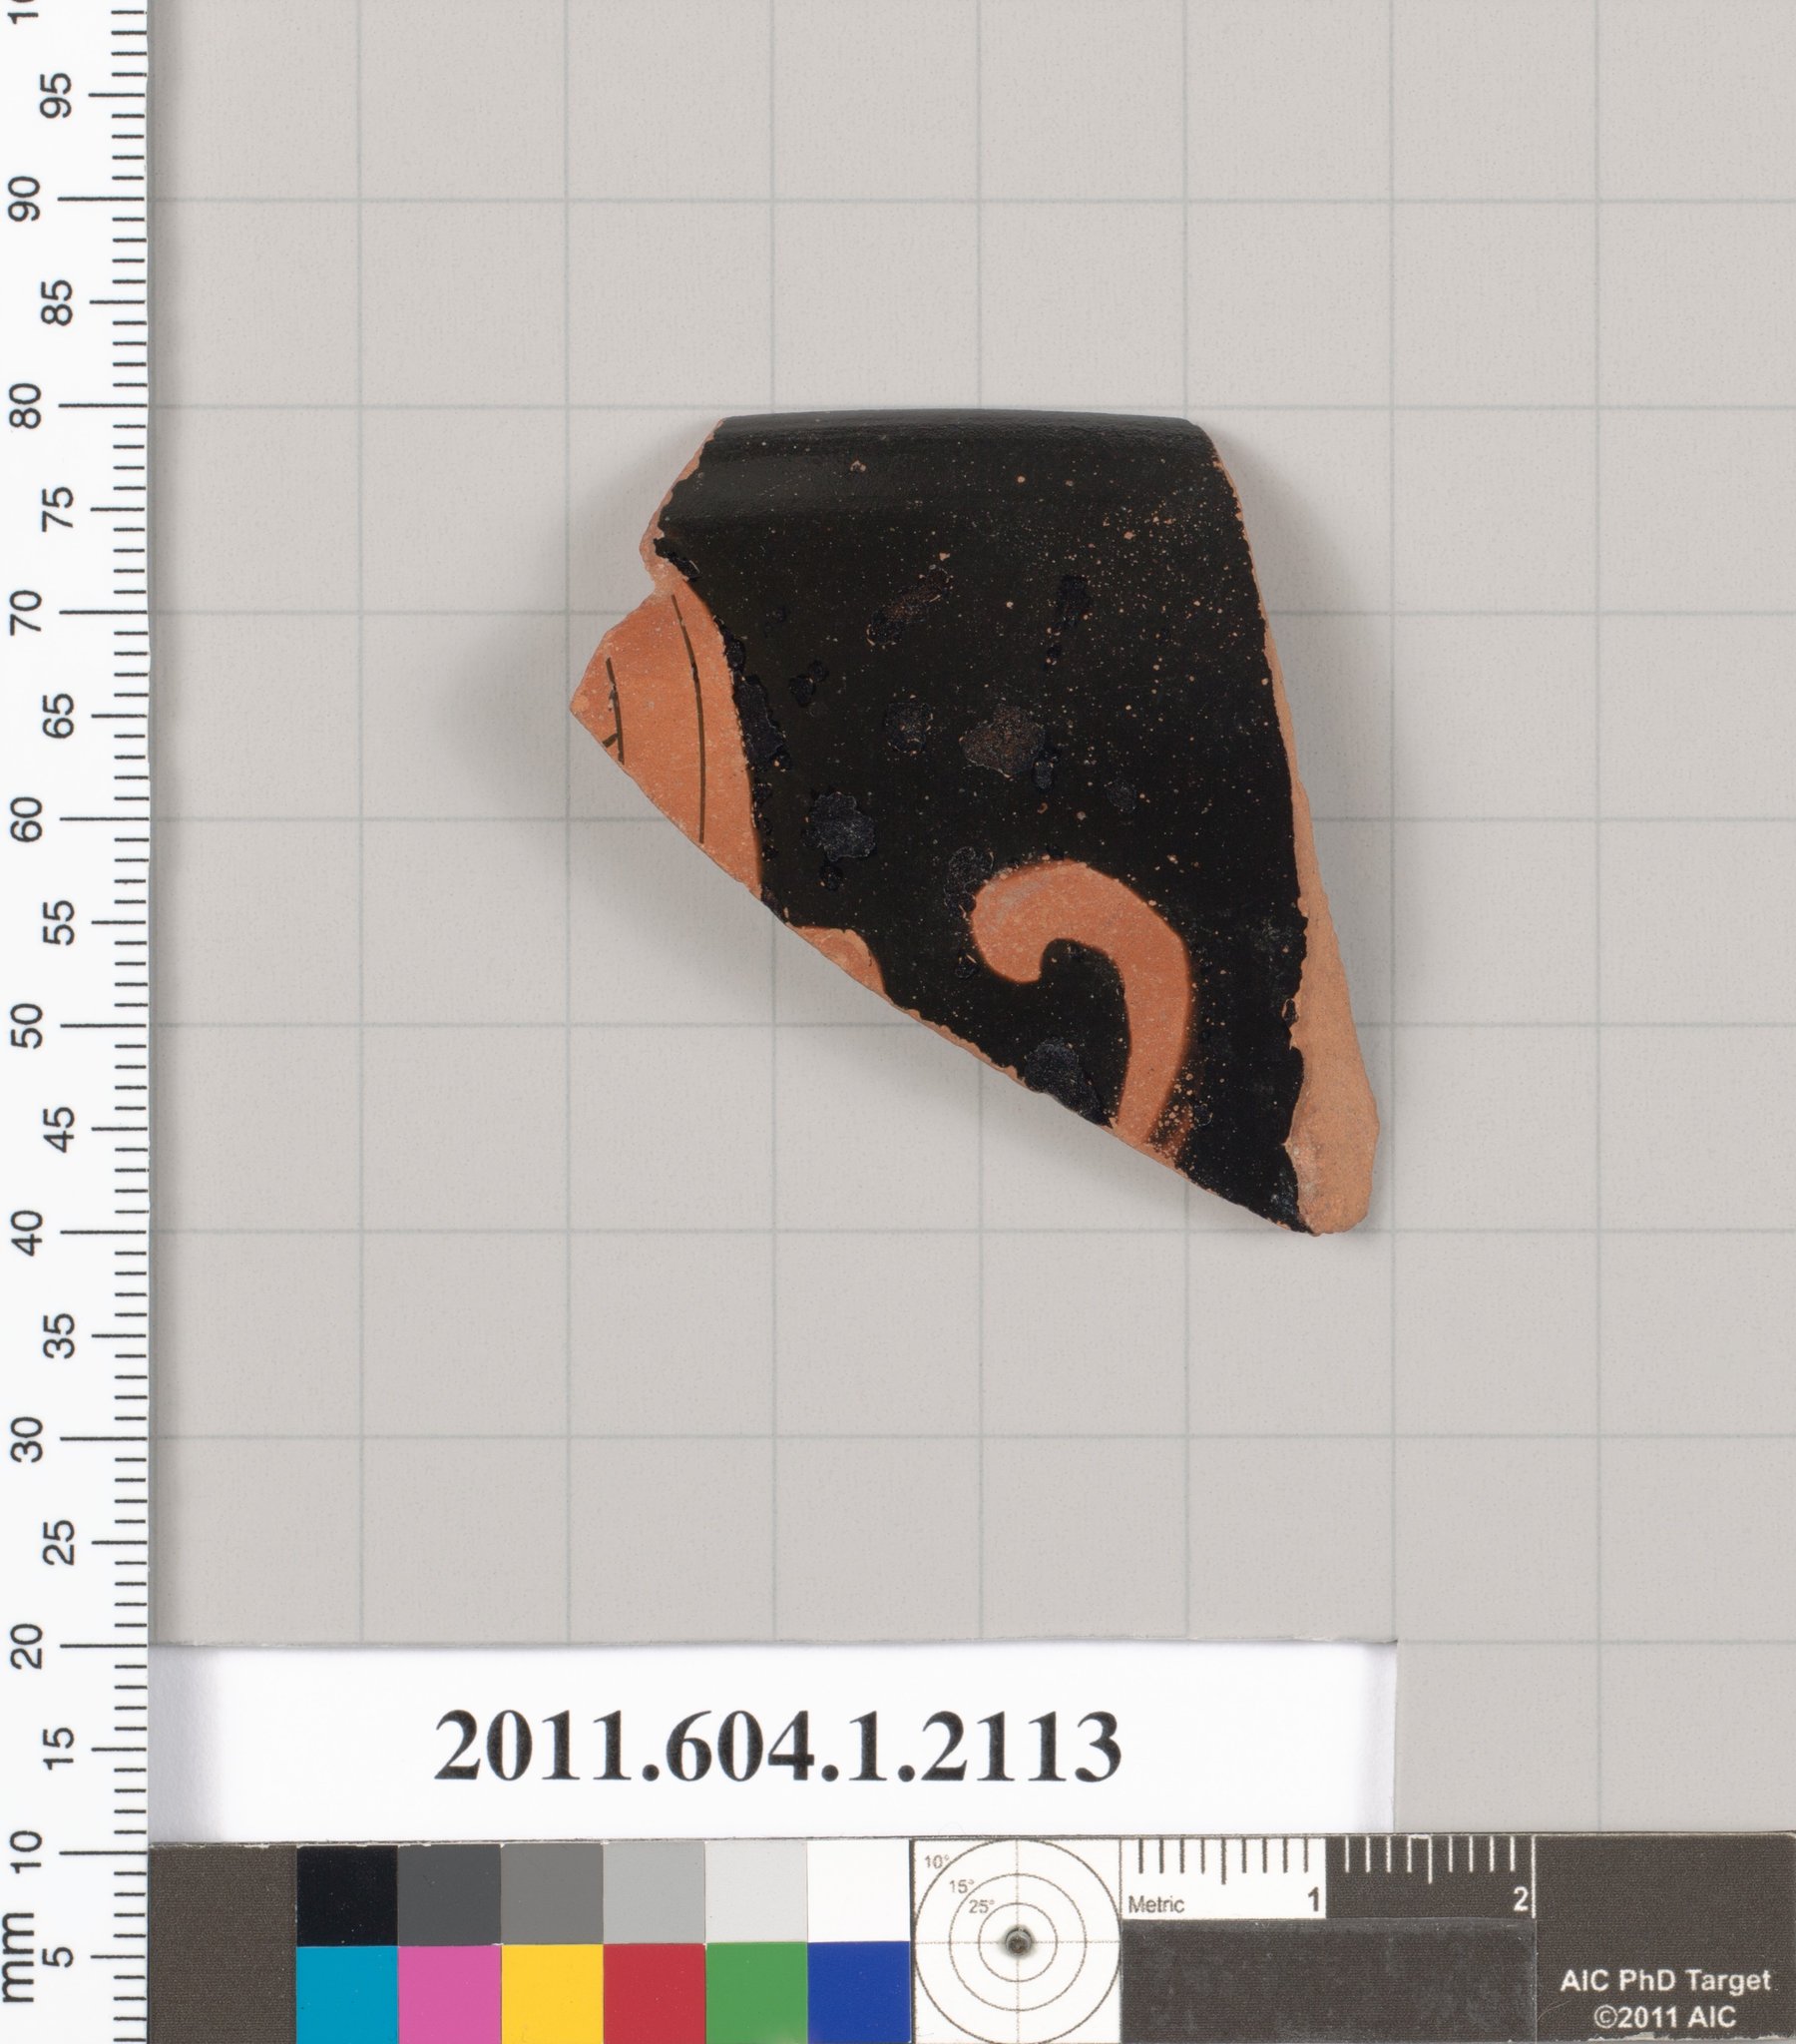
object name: kylix fragment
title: Terracotta rim fragment of a kylix (drinking cup)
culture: greek, attic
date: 475-451 BCE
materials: terracotta